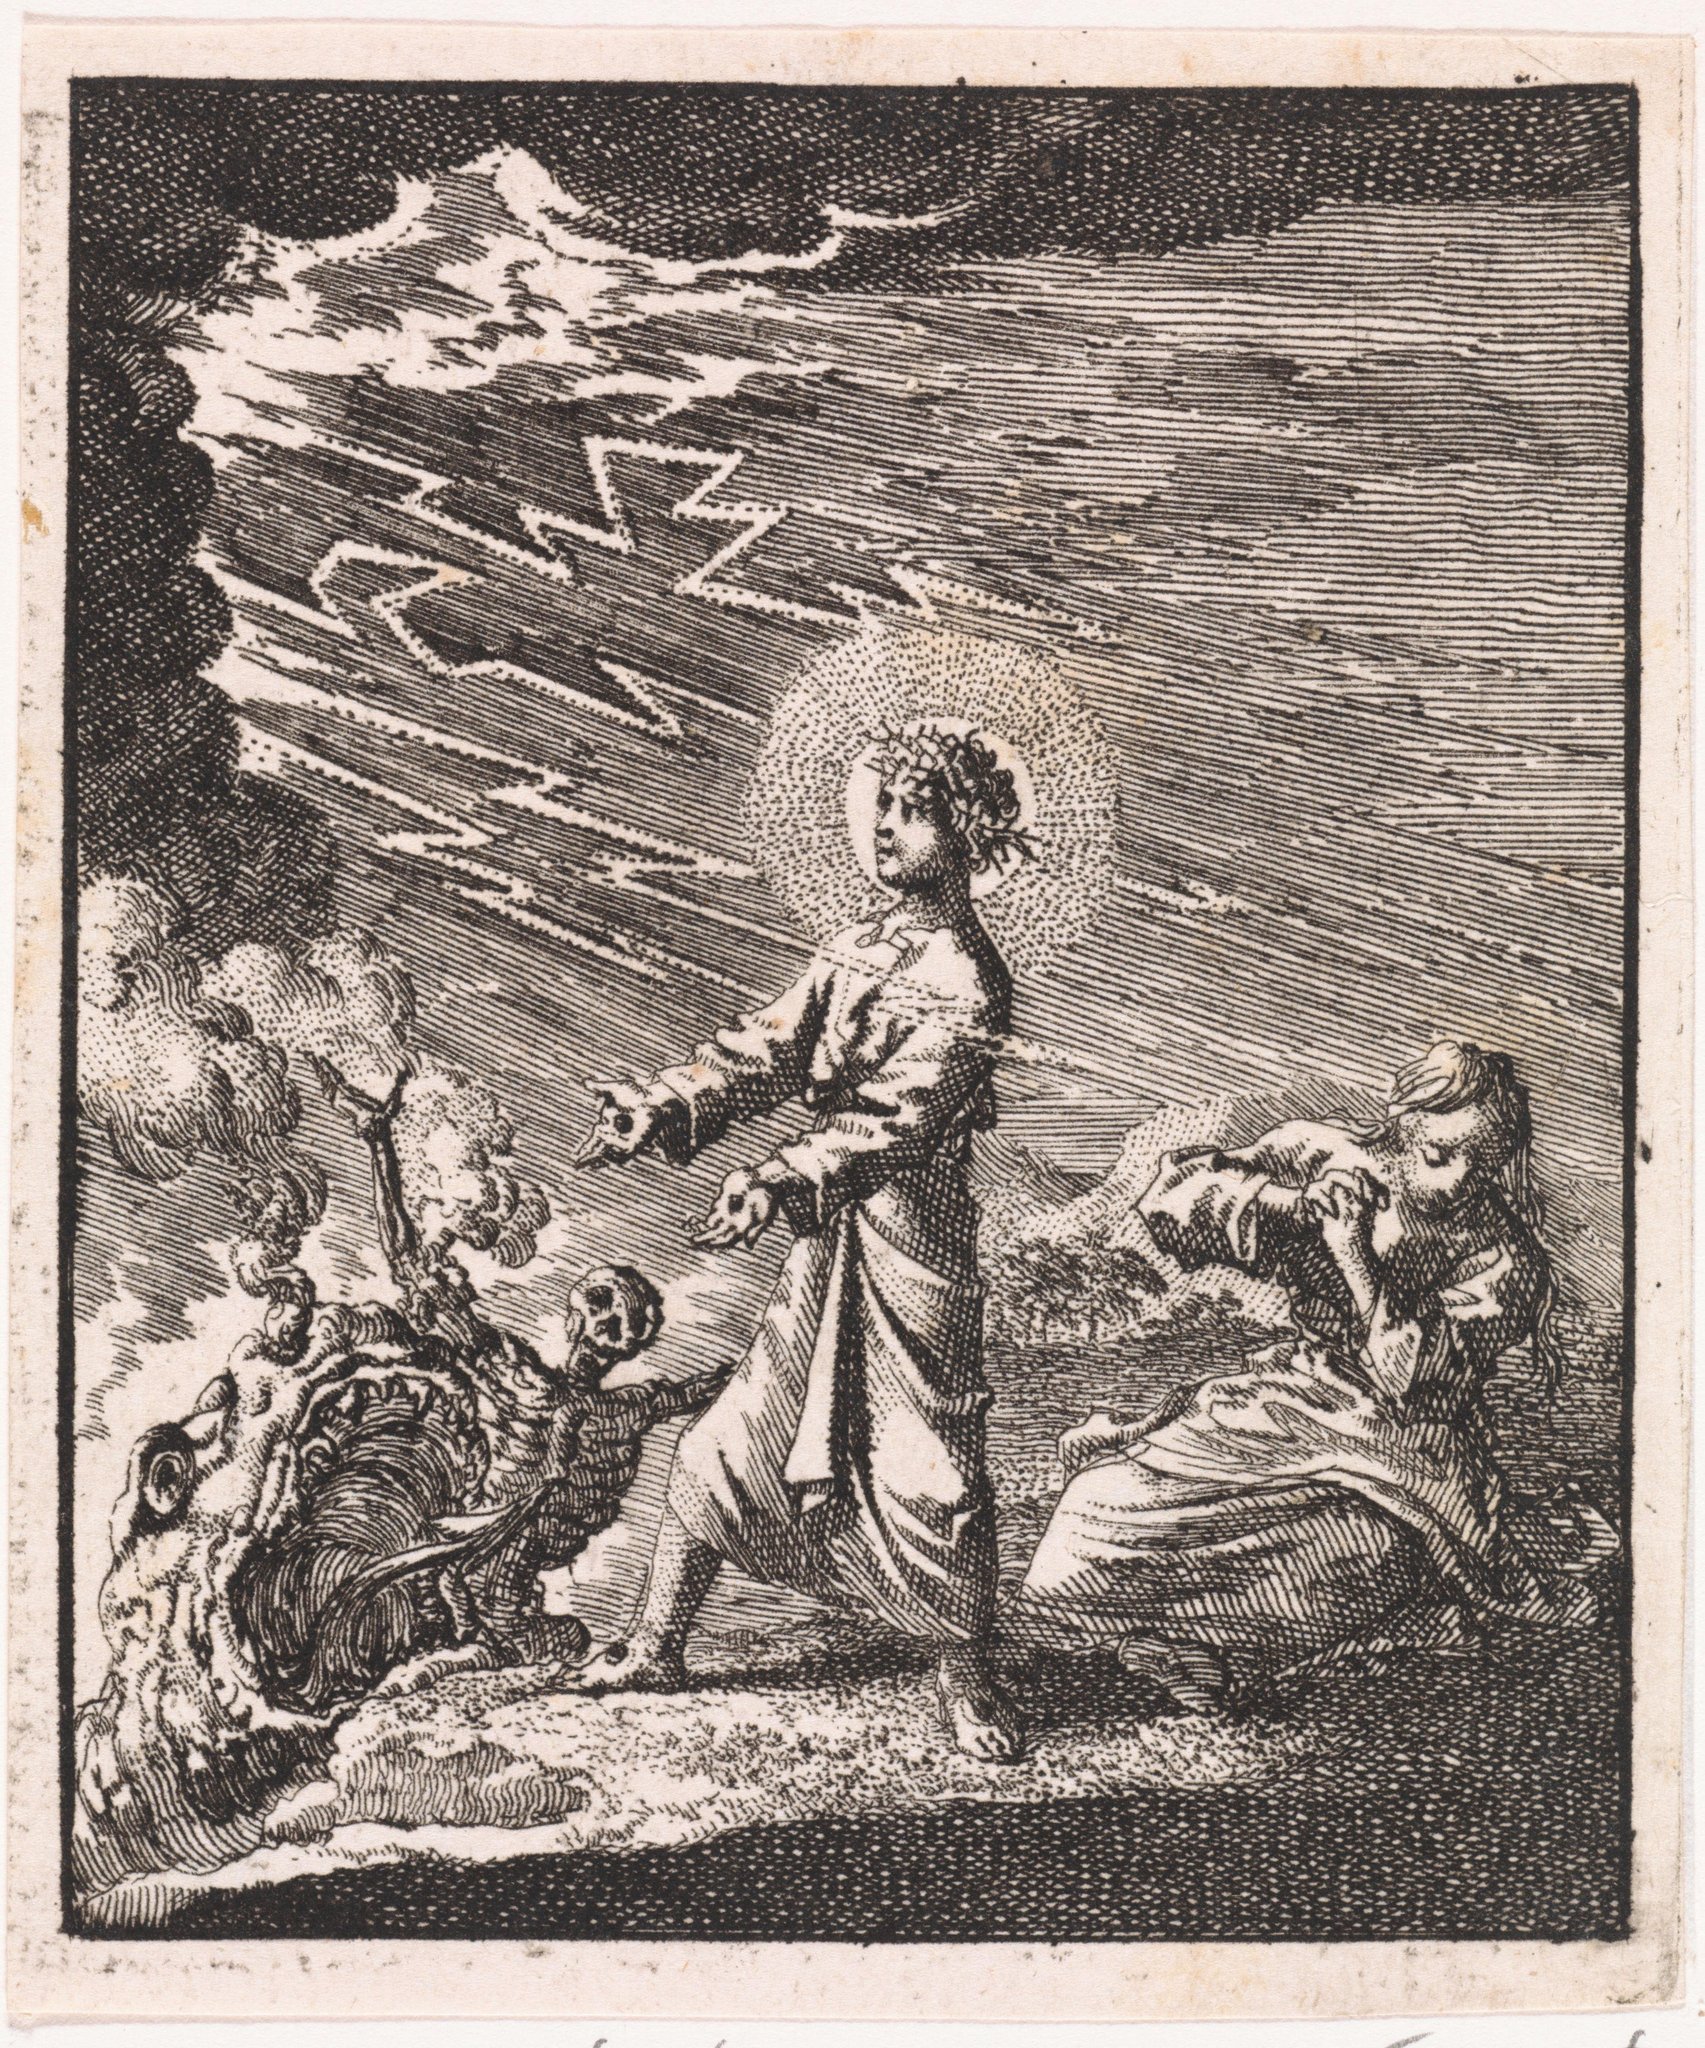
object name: print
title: Christus verdedigt de gepersonifieerde ziel tegen de hel en de dood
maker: jan luyken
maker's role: draughtsman, print maker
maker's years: 1649-1712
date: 1714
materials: paper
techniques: etching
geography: amsterdam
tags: symbols of hell, symbols of death, christ and the soul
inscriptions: collector's mark: Lugt 2228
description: Proefdruk van illustratie uit: Luyken, Jan. Jezus en de Ziel, 3 delen. Amsterdam: Wed. Pieter Arentsz II en Cornelis van der Sys, 1714, dl. II, p. 105.